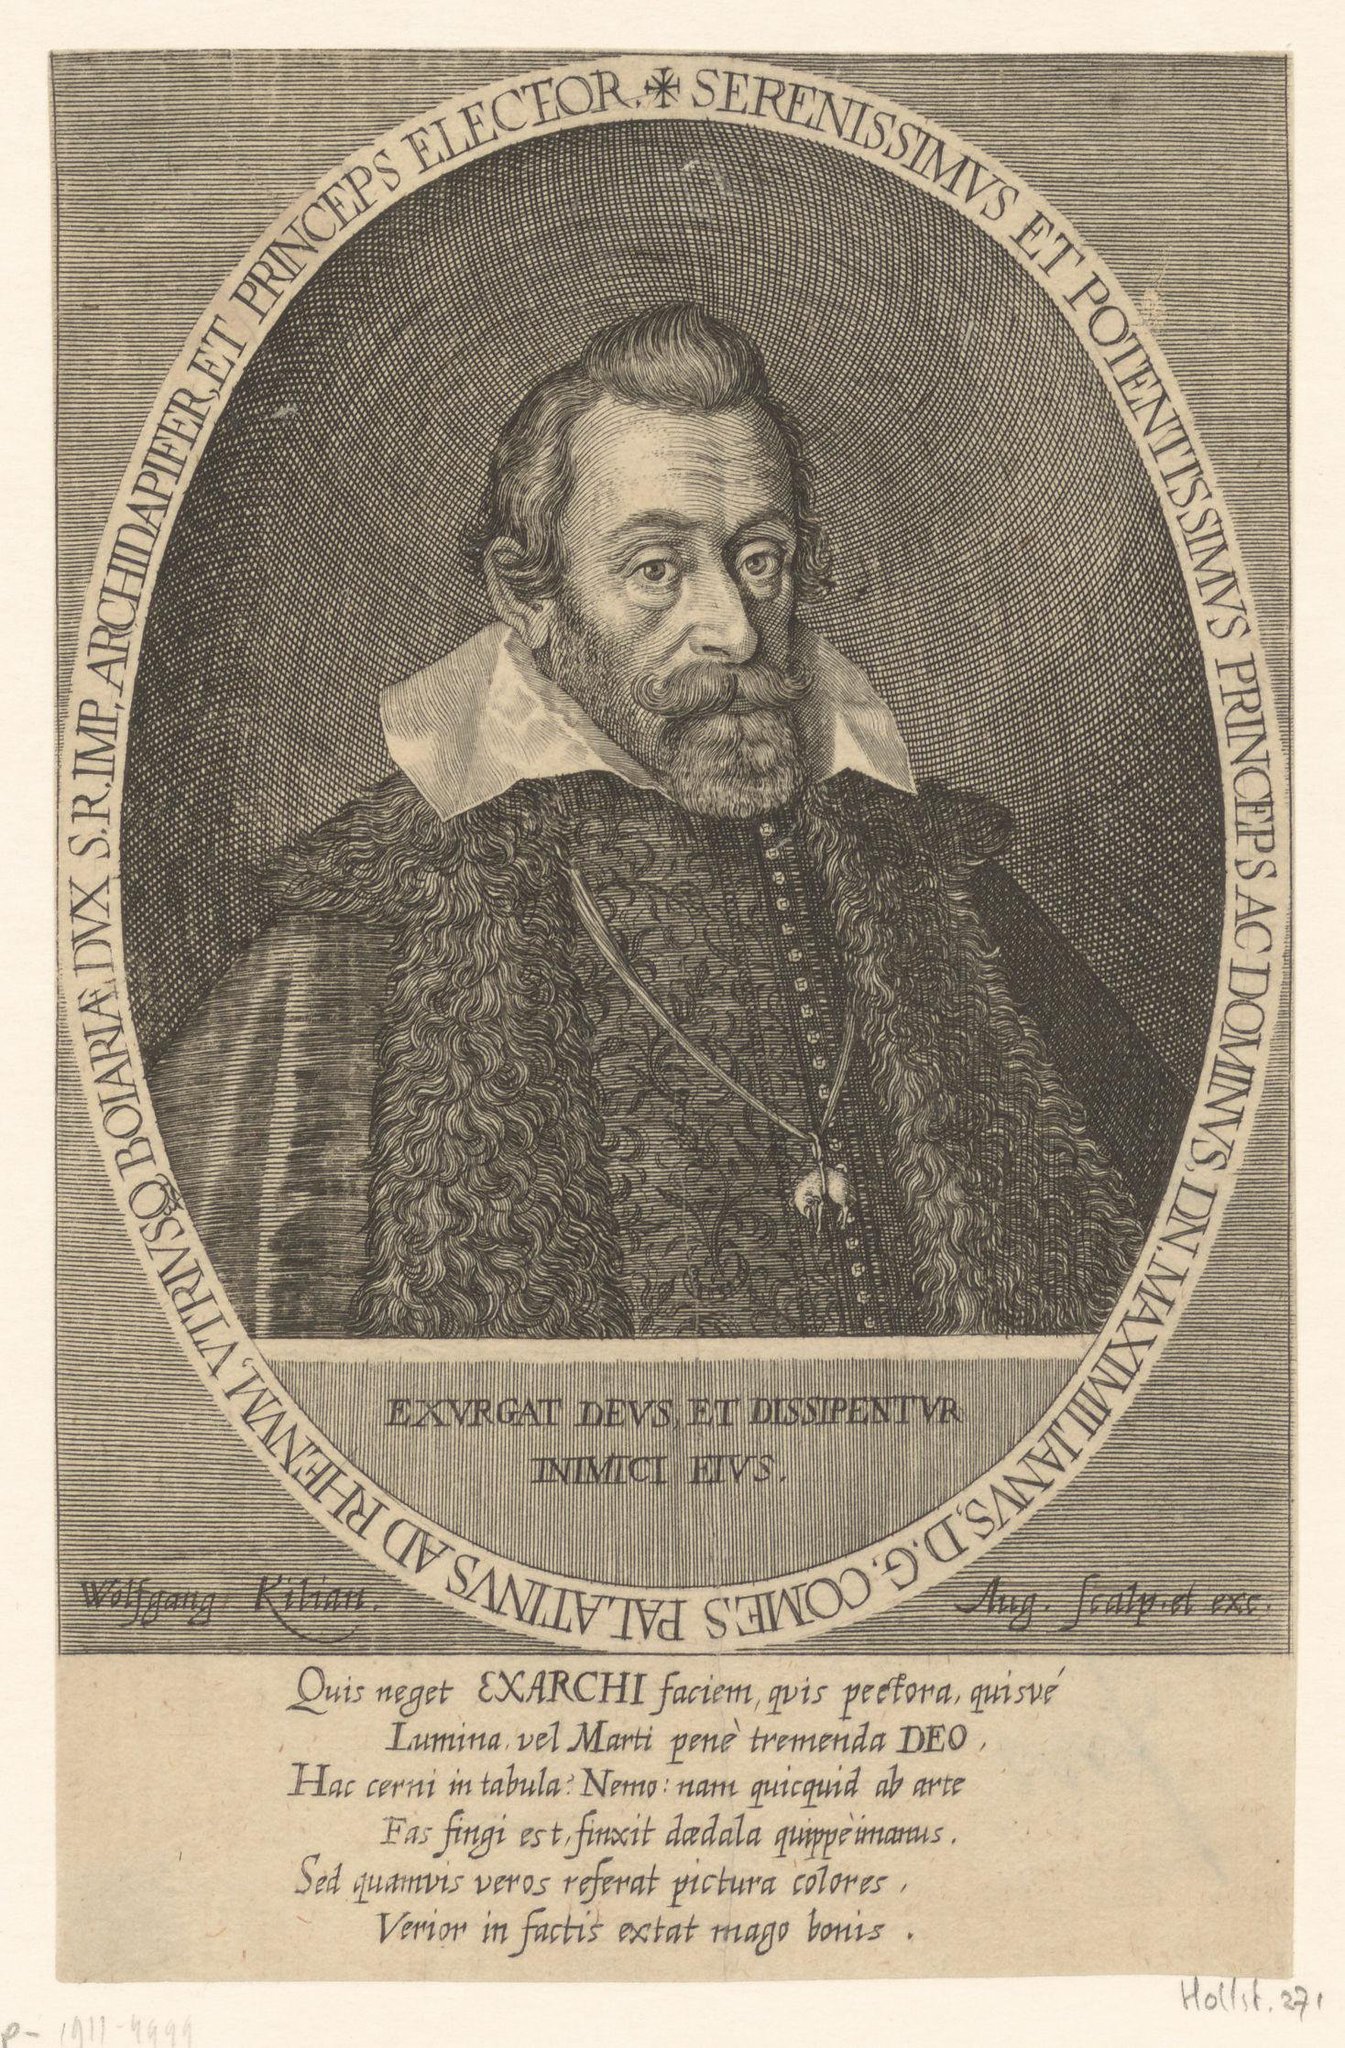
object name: print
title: Portret van Maximilian I van Beieren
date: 1597-1662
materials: paper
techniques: engraving, etching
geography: augsburg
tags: maximiliaan i (keurvorst van beieren), historical persons, knighthood order of the golden fleece - insignia of a knighthood order, e.g.: badge, chain (with name of order), regent, substitute ruler; viceroy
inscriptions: collector's mark: Lugt 2228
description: Tekst in het Latijn in de omlijsting en in de ondermarge.